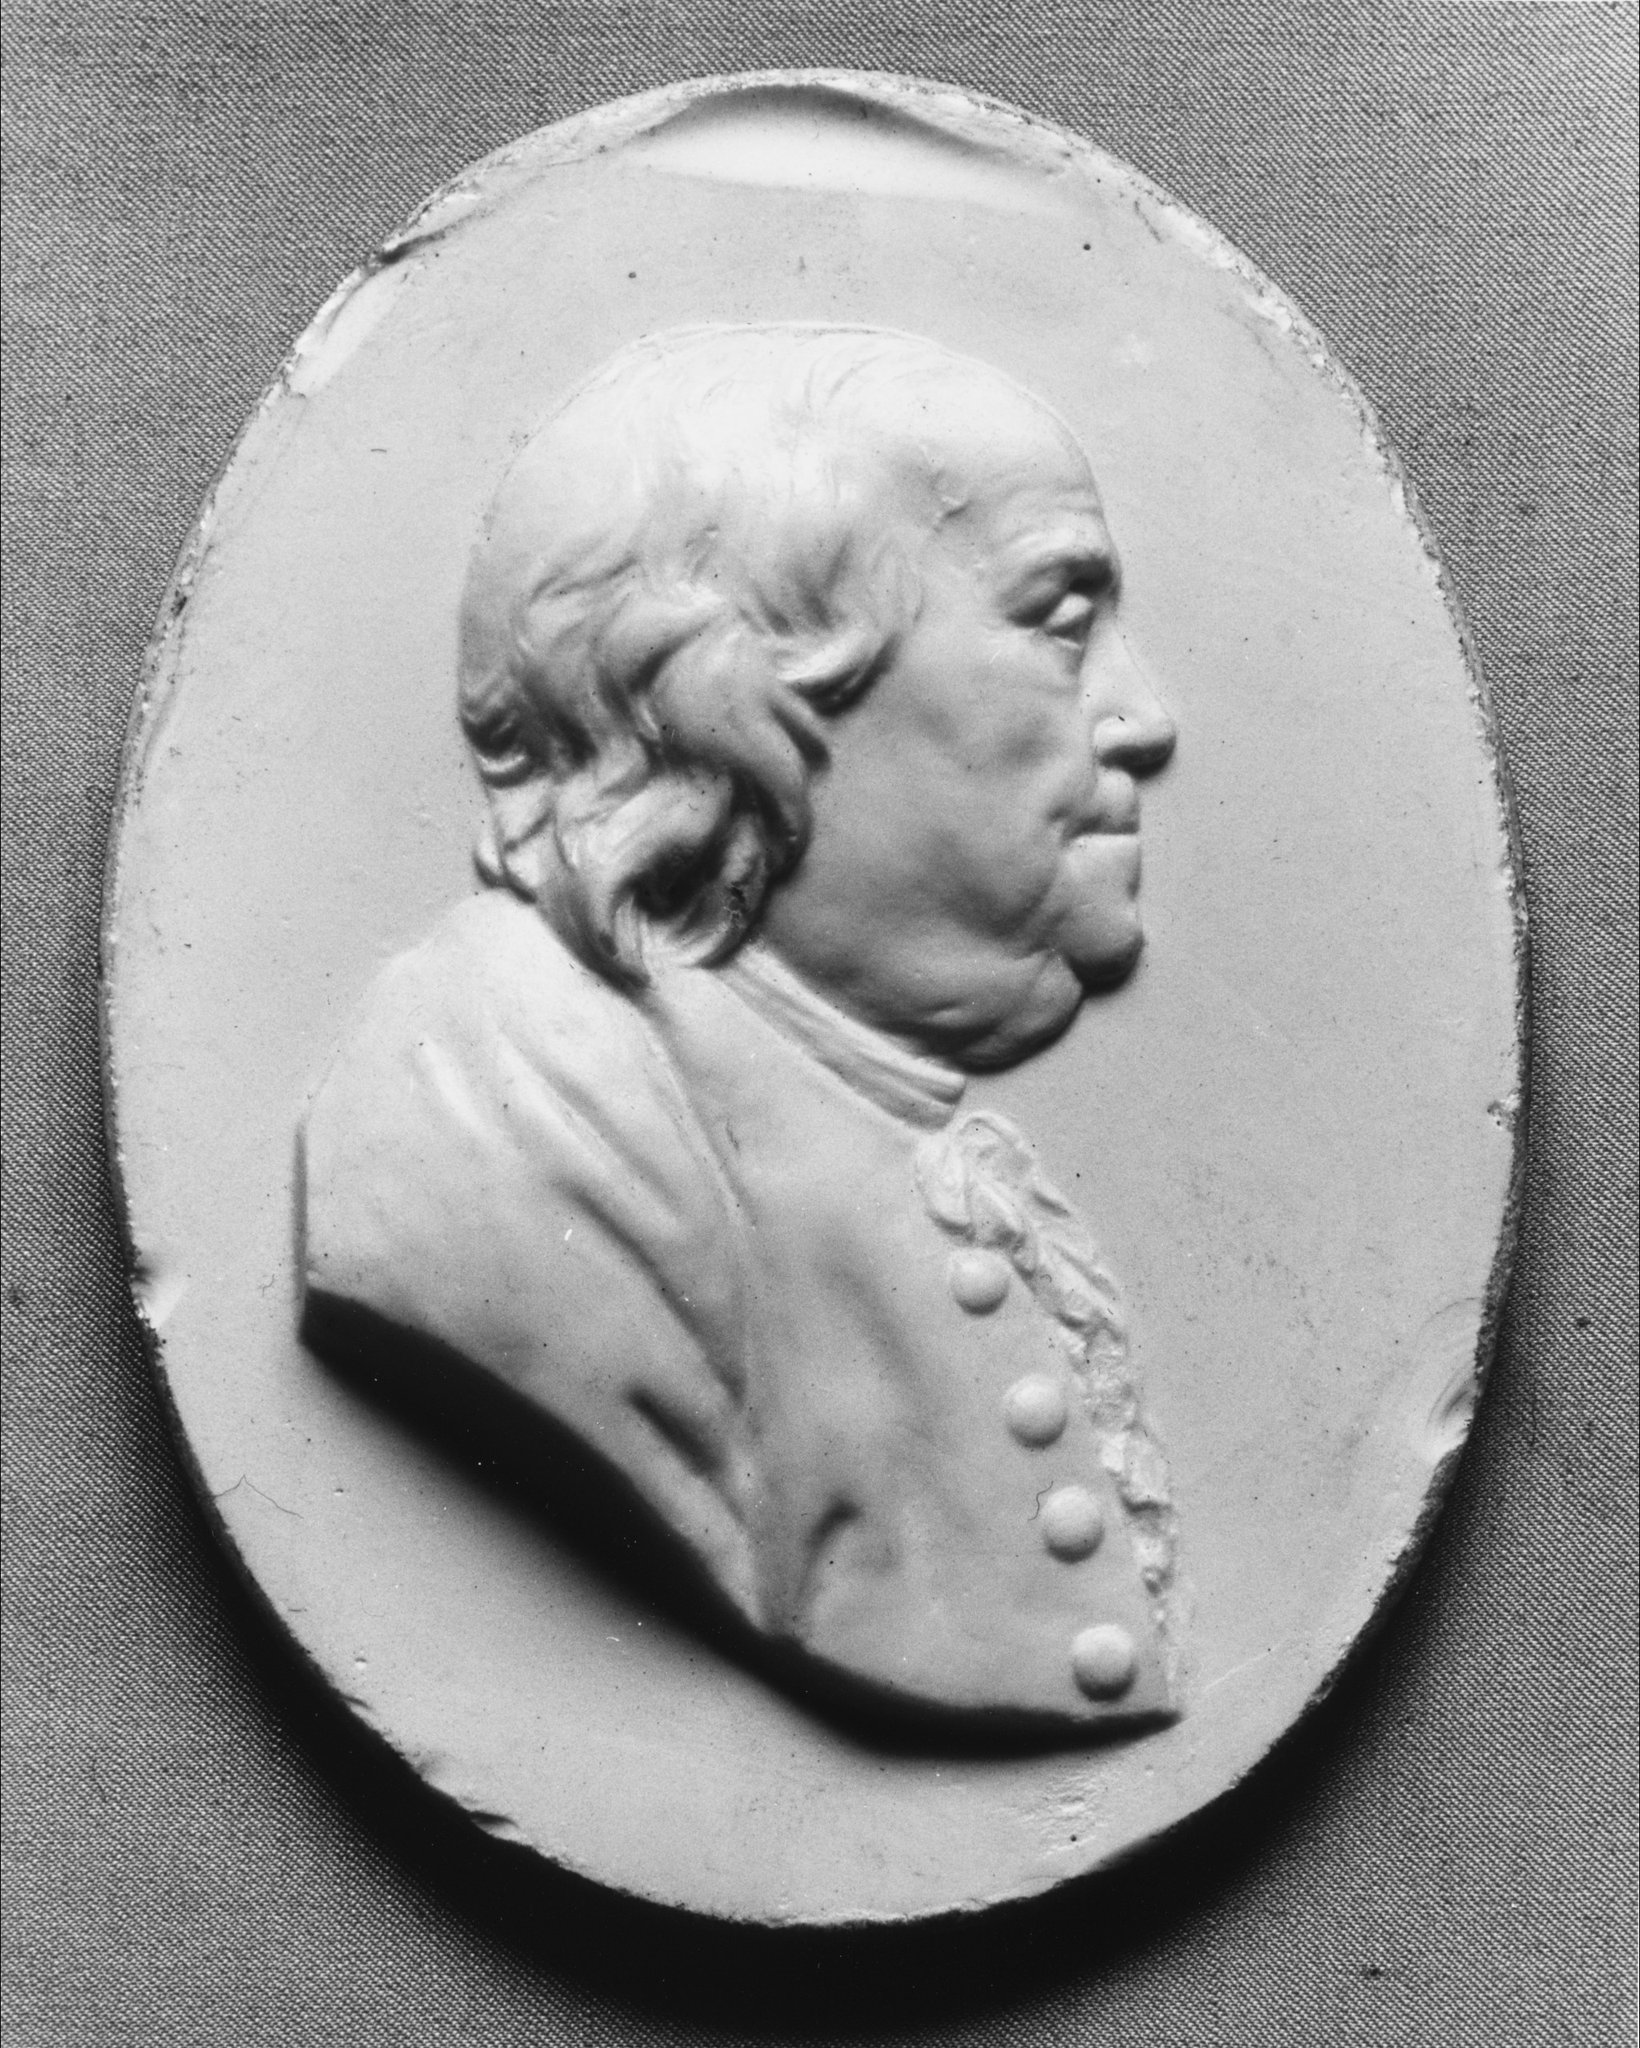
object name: plaque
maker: james tassie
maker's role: artist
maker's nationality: british, scottish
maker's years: 1735-1799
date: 1776-1825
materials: glass, paste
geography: england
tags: benjamin franklin,men,profiles